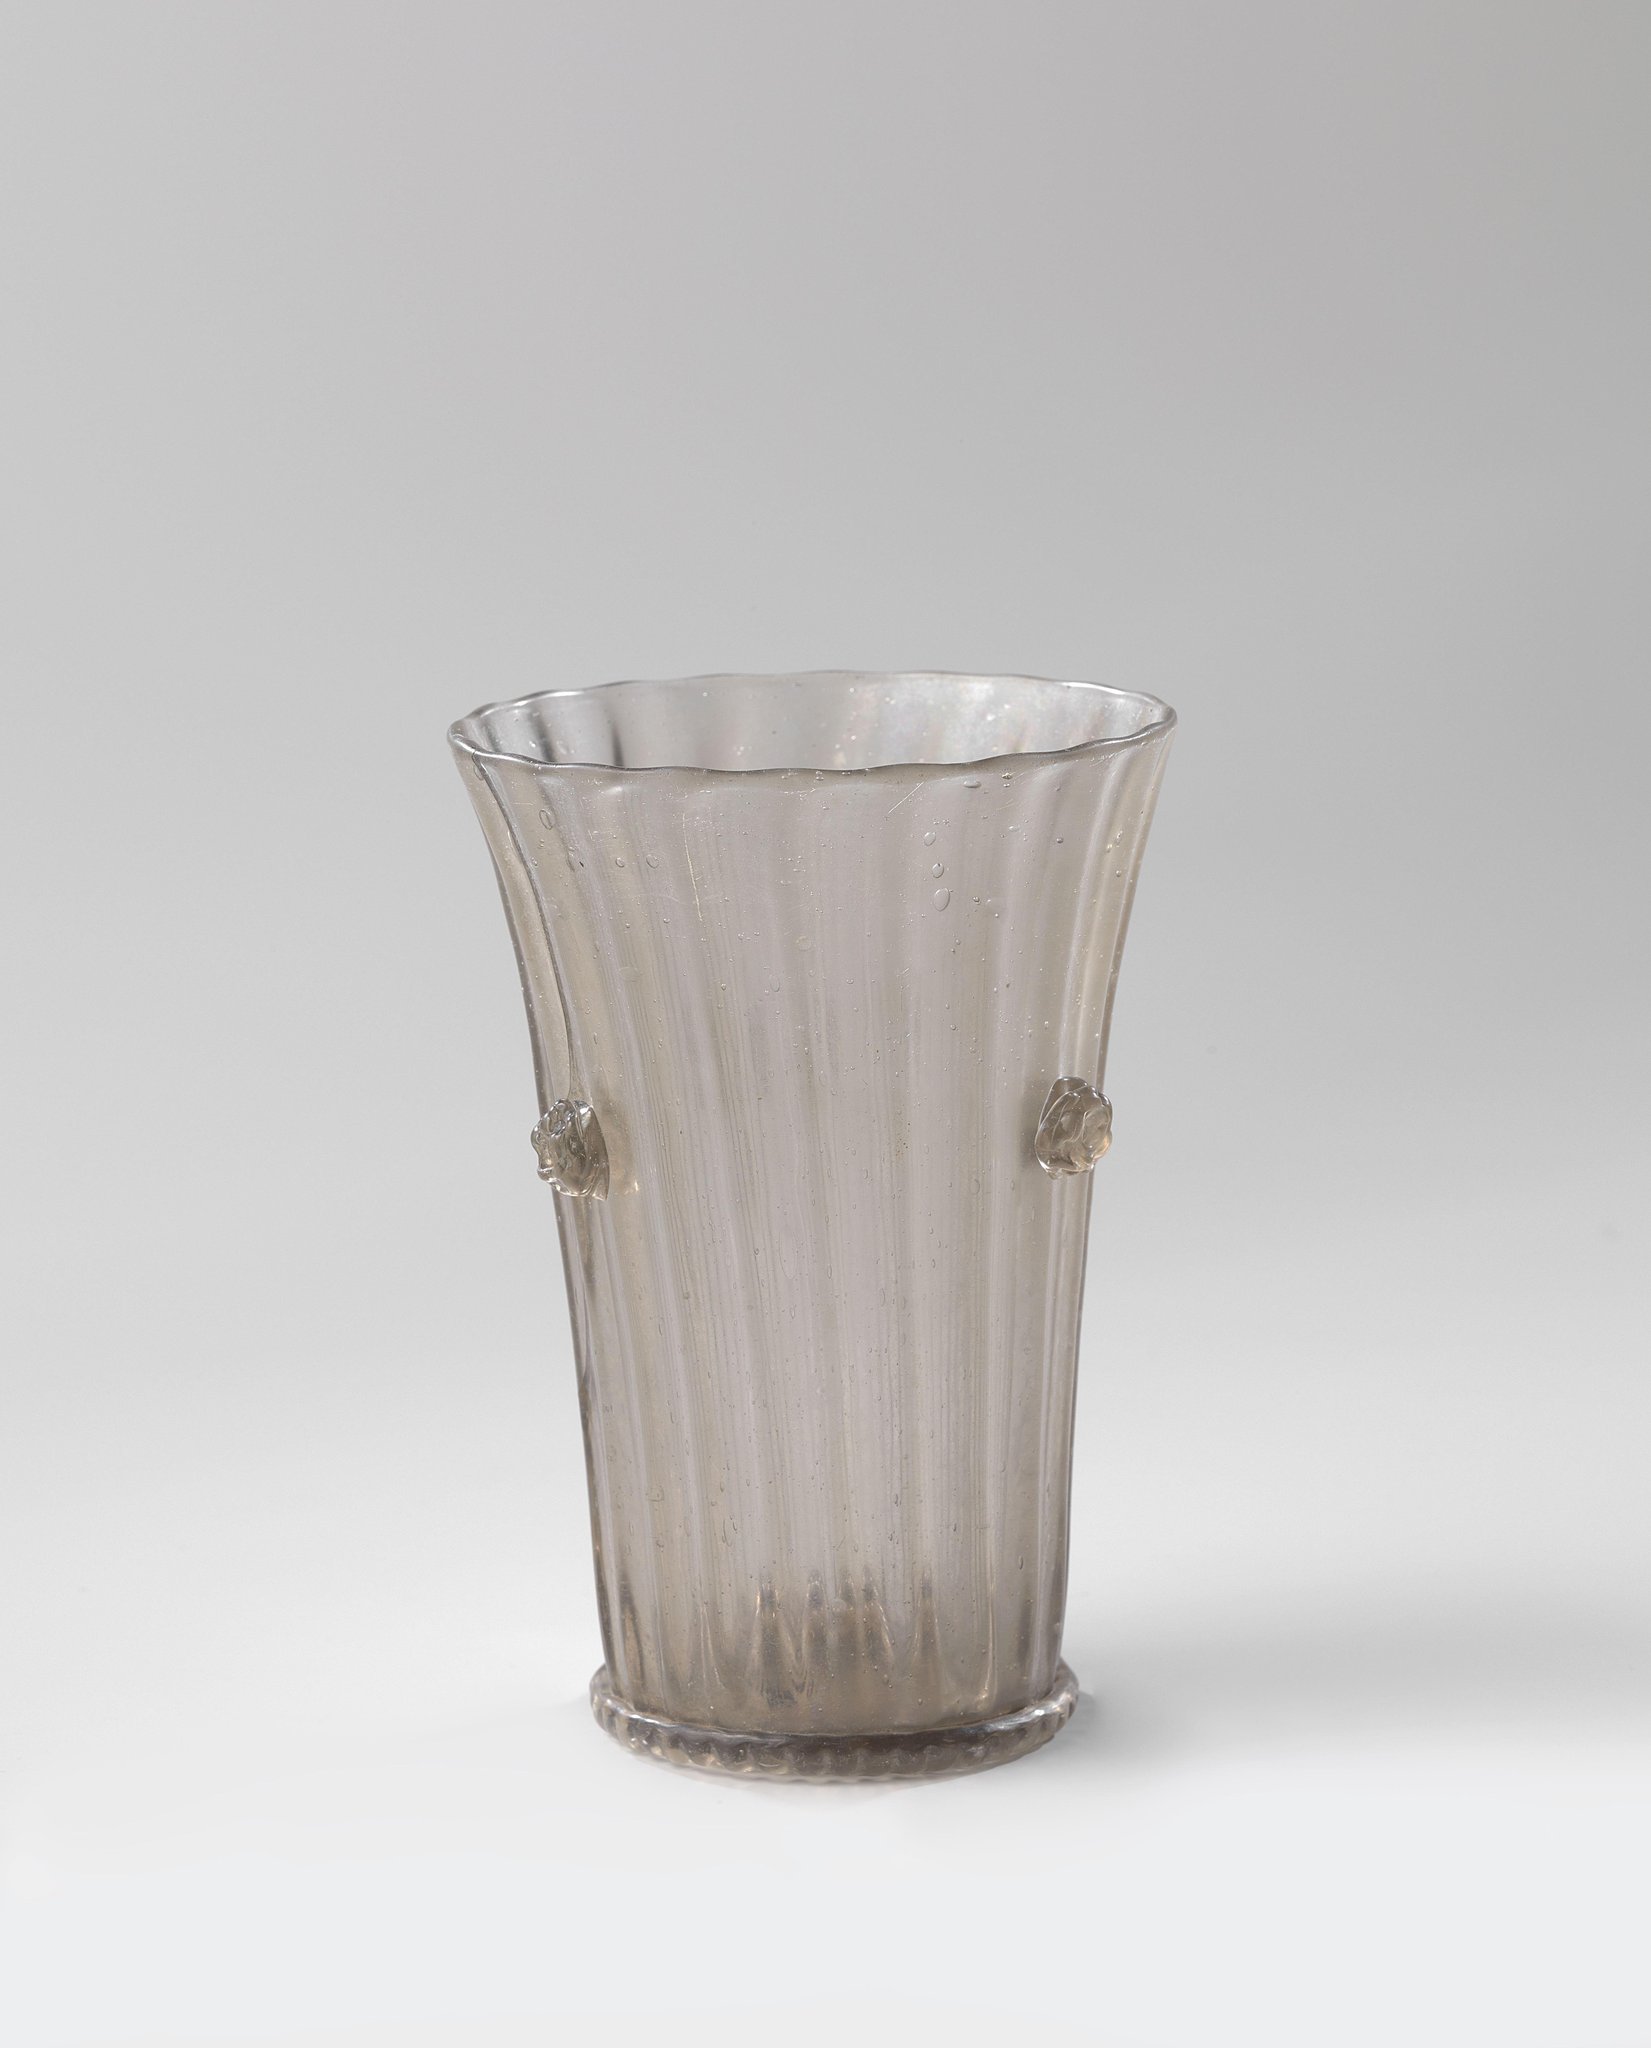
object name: cup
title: Beker met verticale, optisch geblazen ribben en drie noppen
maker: Anonymous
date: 1550-1600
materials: glass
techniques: façon de venise, glassblowing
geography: low countries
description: Beker met ingestoken bodem, geribde standring. Bekervormig, zich verwijdend lichaam met verticale, optisch geblazen ribben en drie noppen